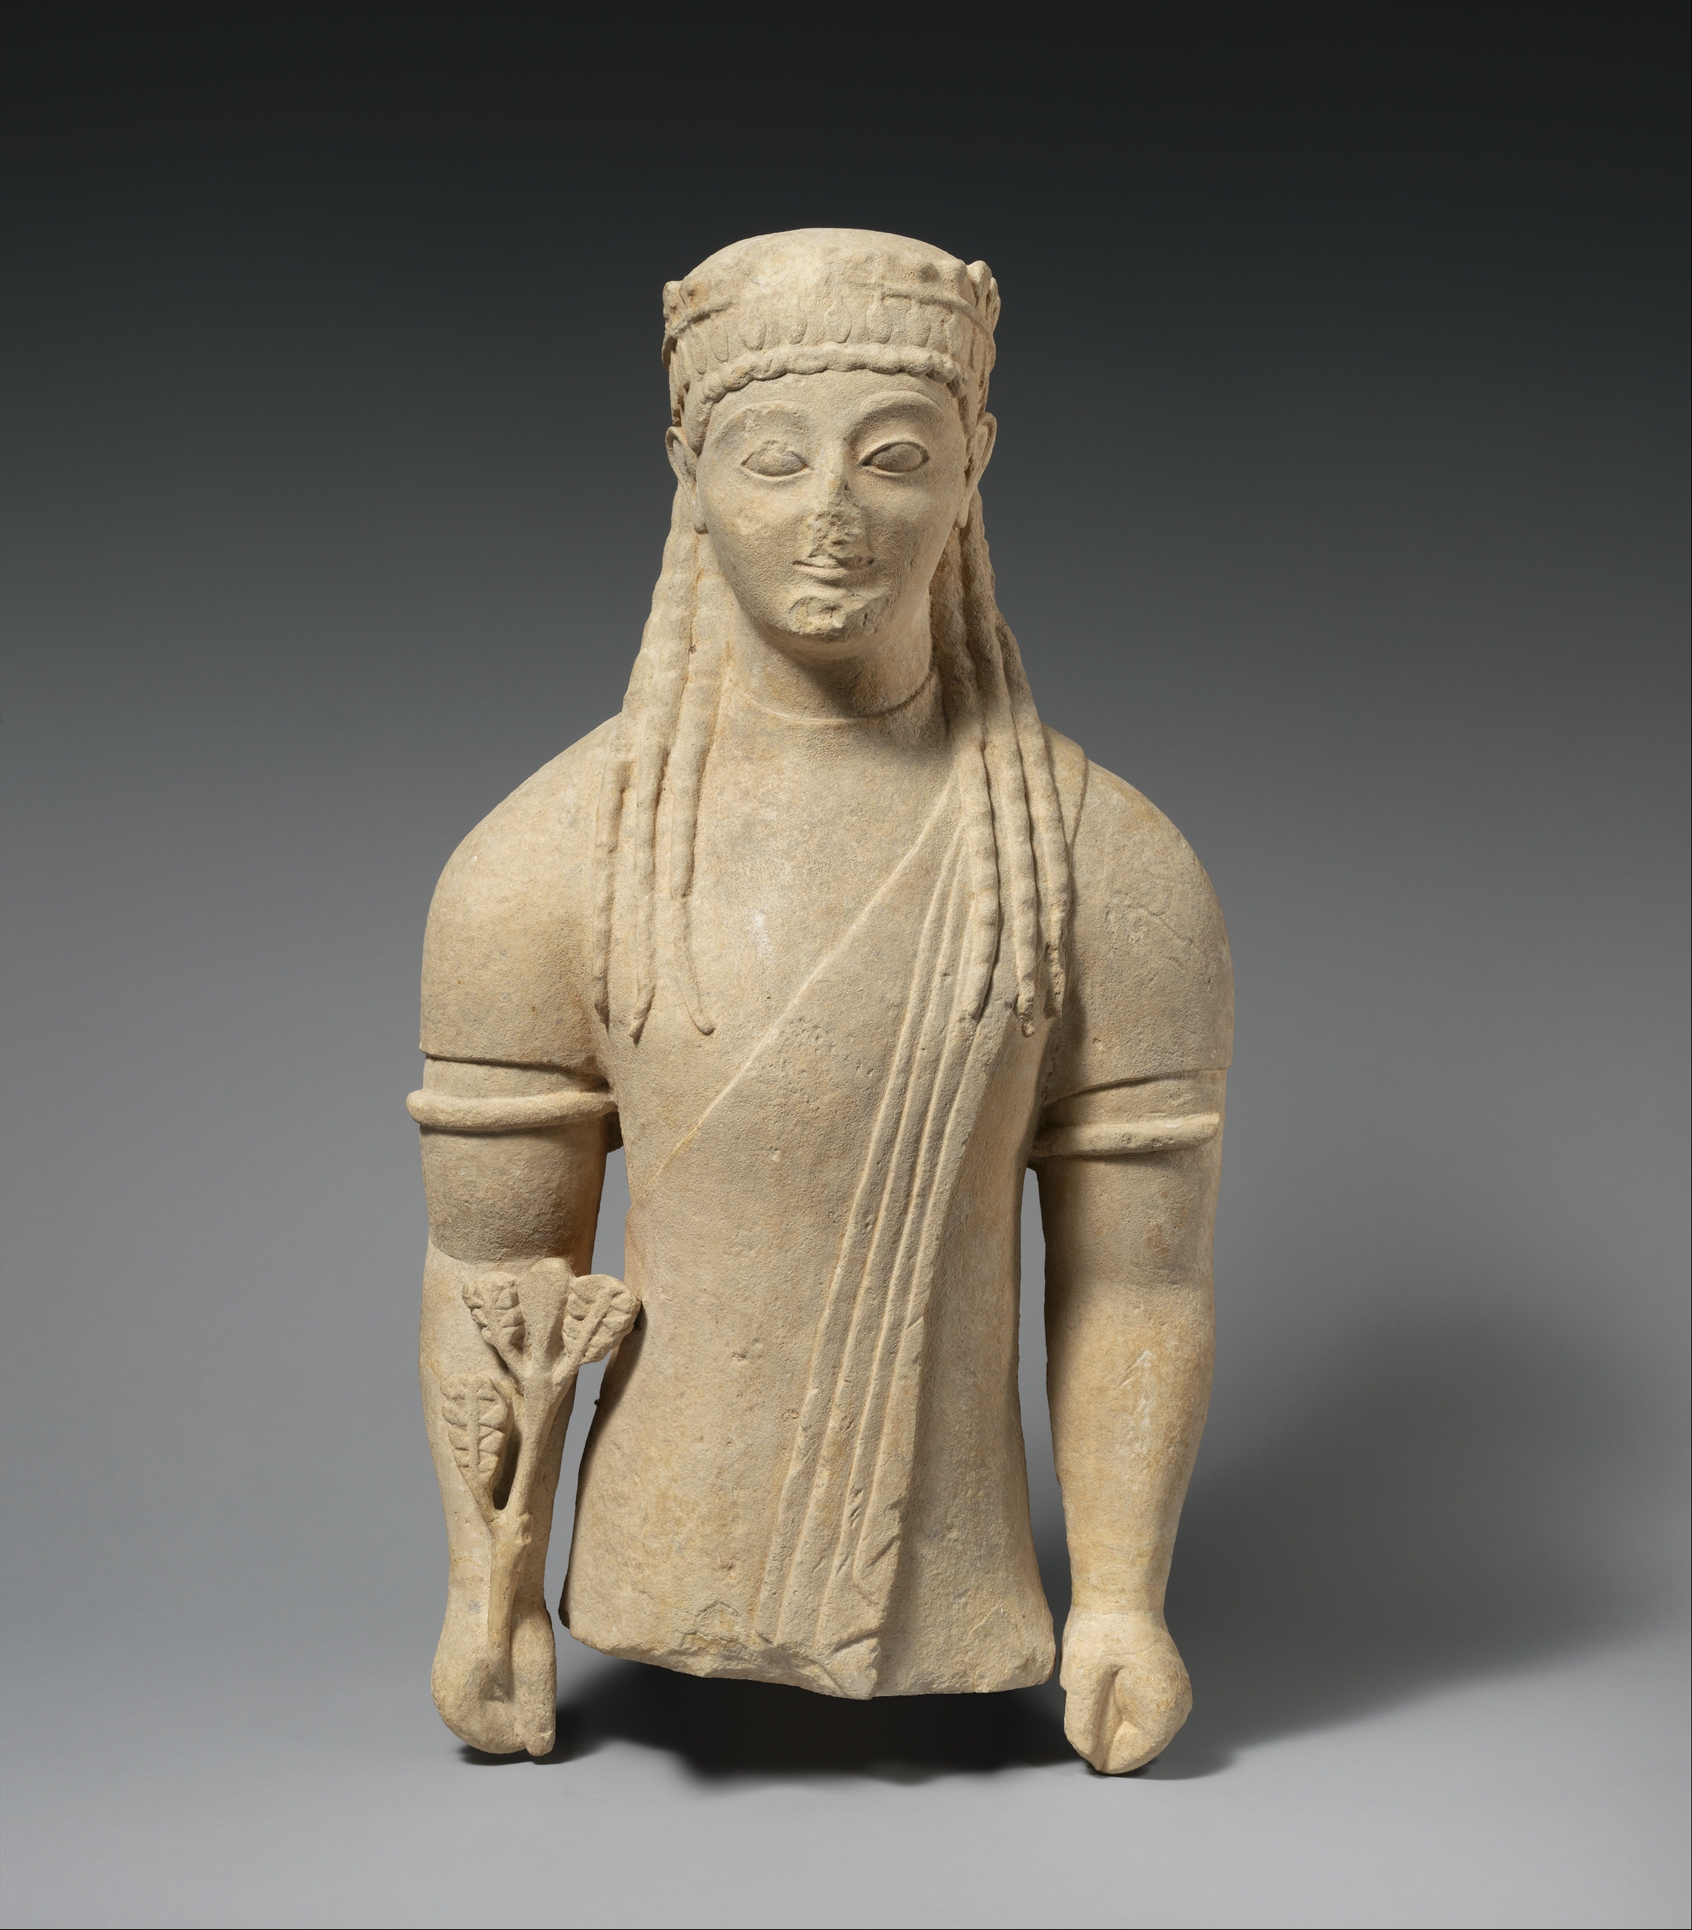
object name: statue of a youth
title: Limestone statue of a beardless male votary with a wreath of leaves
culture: cypriot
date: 550-525 BCE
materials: limestone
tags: men,wreaths